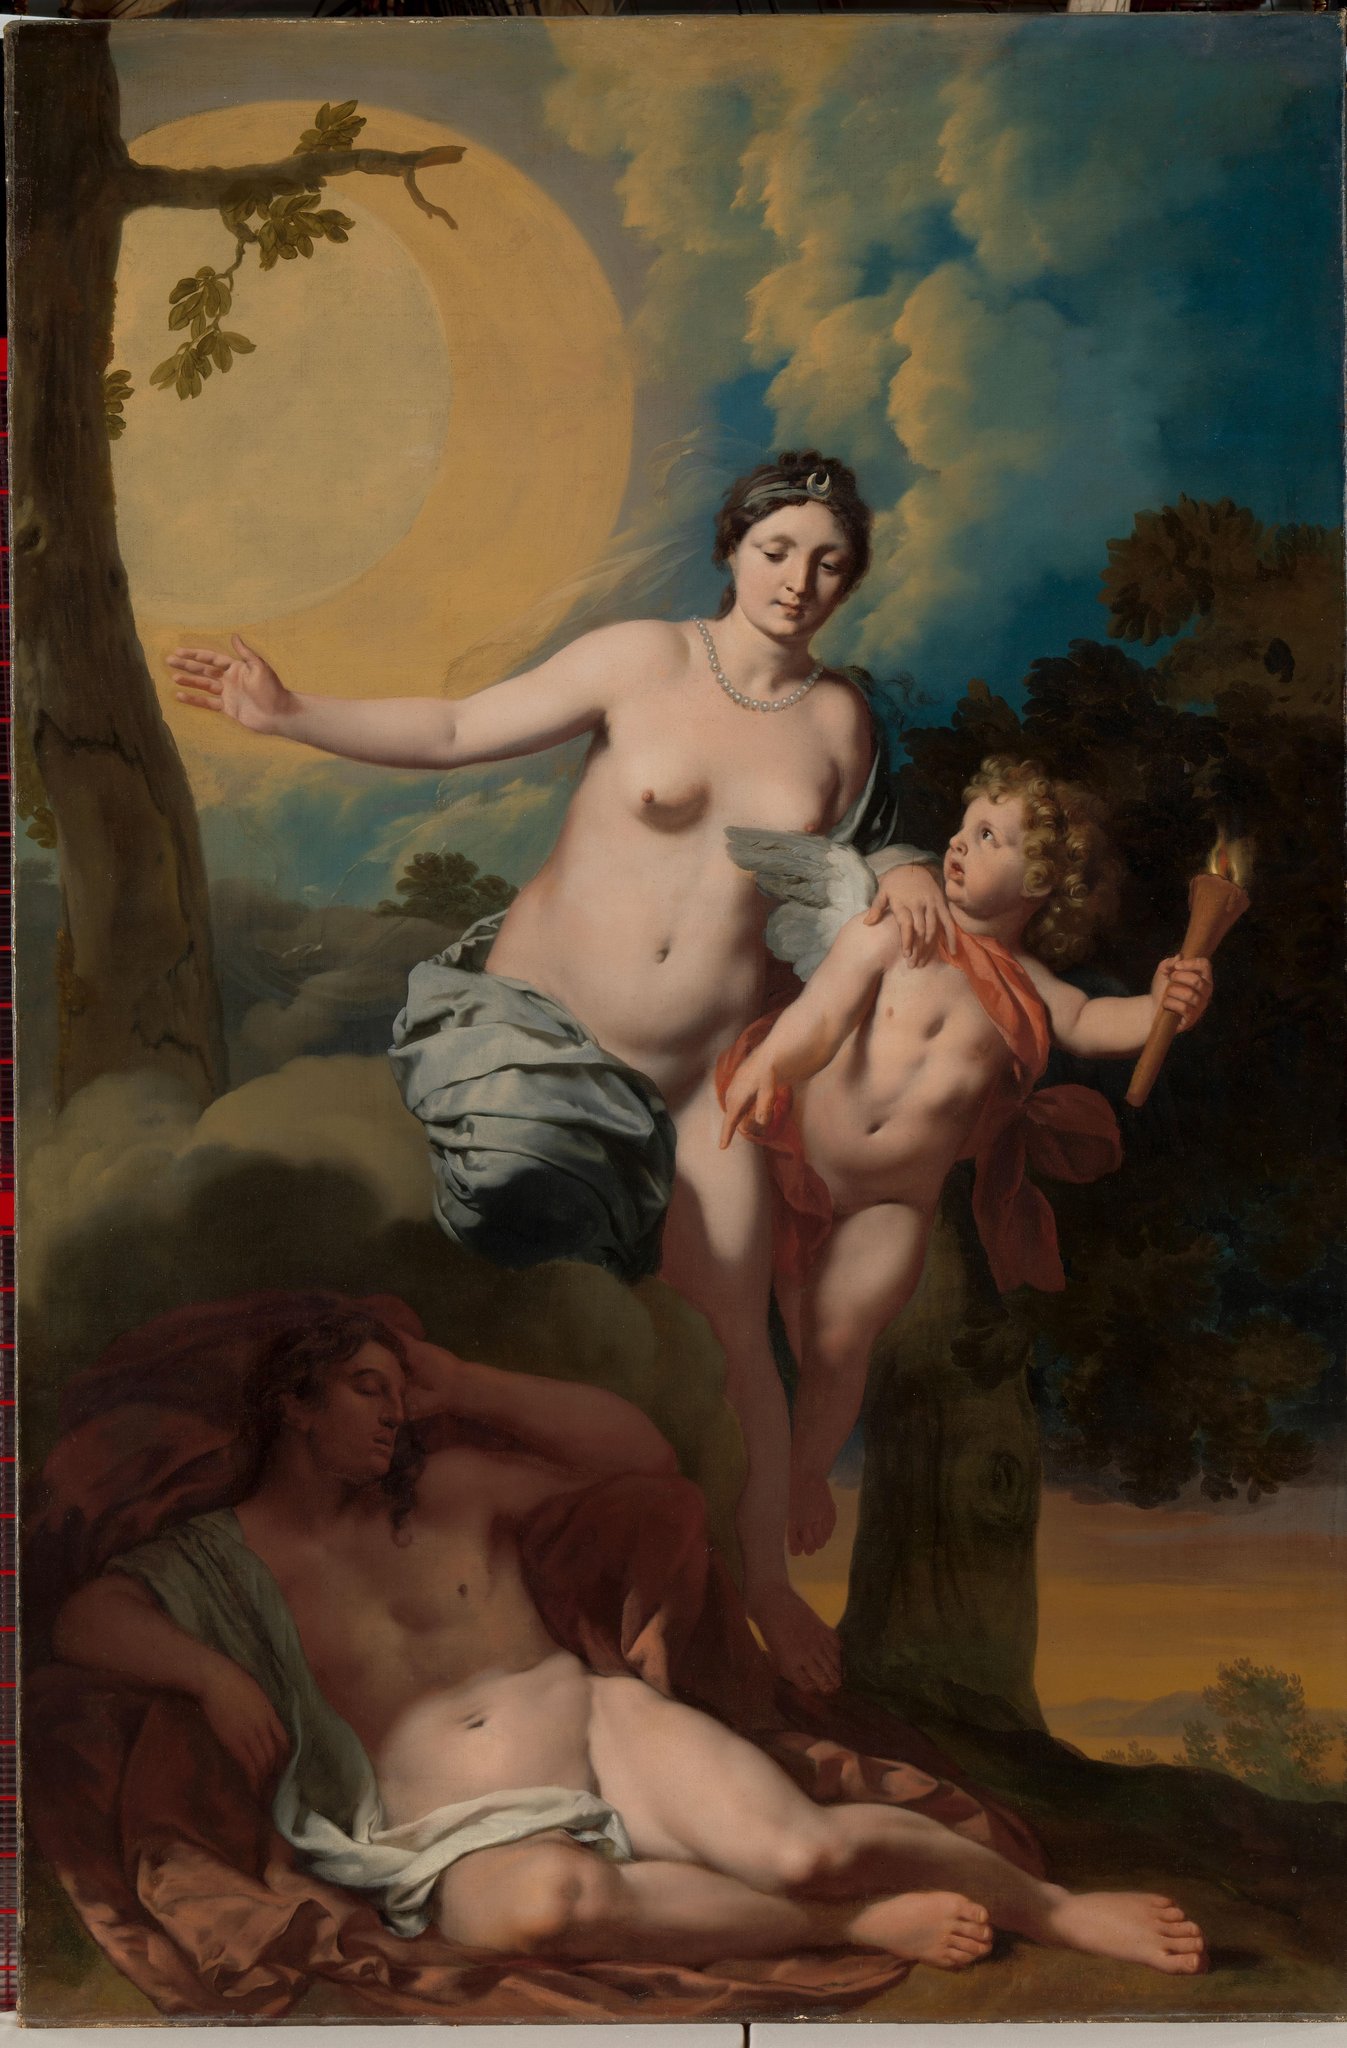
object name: painting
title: Selene and Endymion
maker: gerard de lairesse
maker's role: draughtsman, painter, print maker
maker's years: 1641-1711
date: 1680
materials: canvas, oil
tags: london, maria ii stuart (koningin van engeland, schotland en ierland), full moon, diana (luna) visiting the sleeping endymion, (story of) cupid, amor (eros)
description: The chaste goddess of the moon, Selene (or Diana), is in love with the shepherd Endymion. Only at night when he is asleep does she quietly creep down to him, accompanied by Cupid, whose torch symbolizes burning love. This painting was (appropriately) hung in Mary Stuart’s bedchamber in Soestdijk Palace, for Lairesse felt that the function and decoration of a room should correspond.